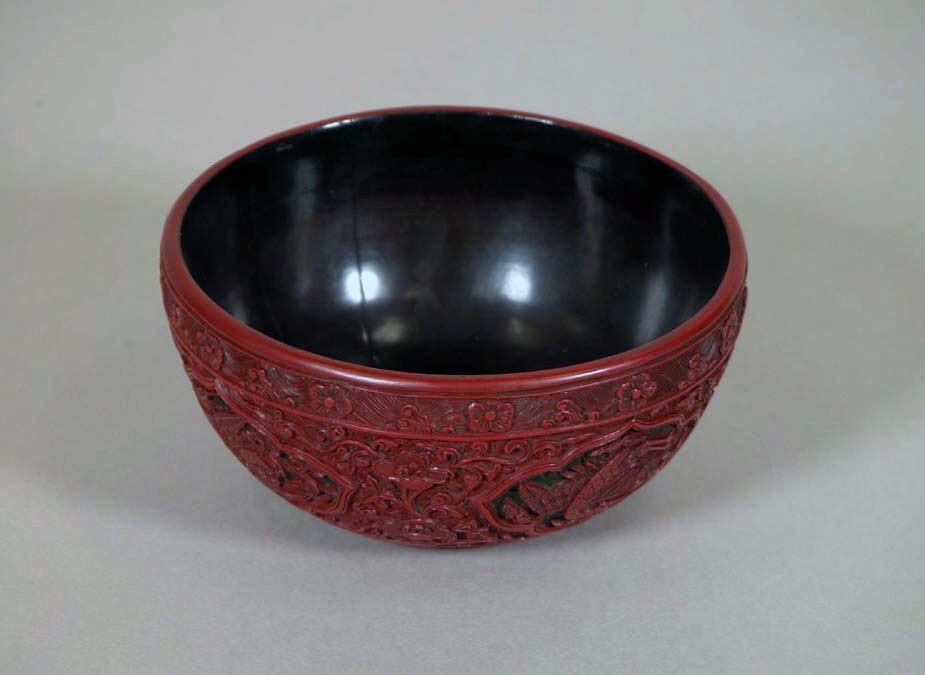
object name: bowl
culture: chinese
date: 1522-1566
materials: lacquer